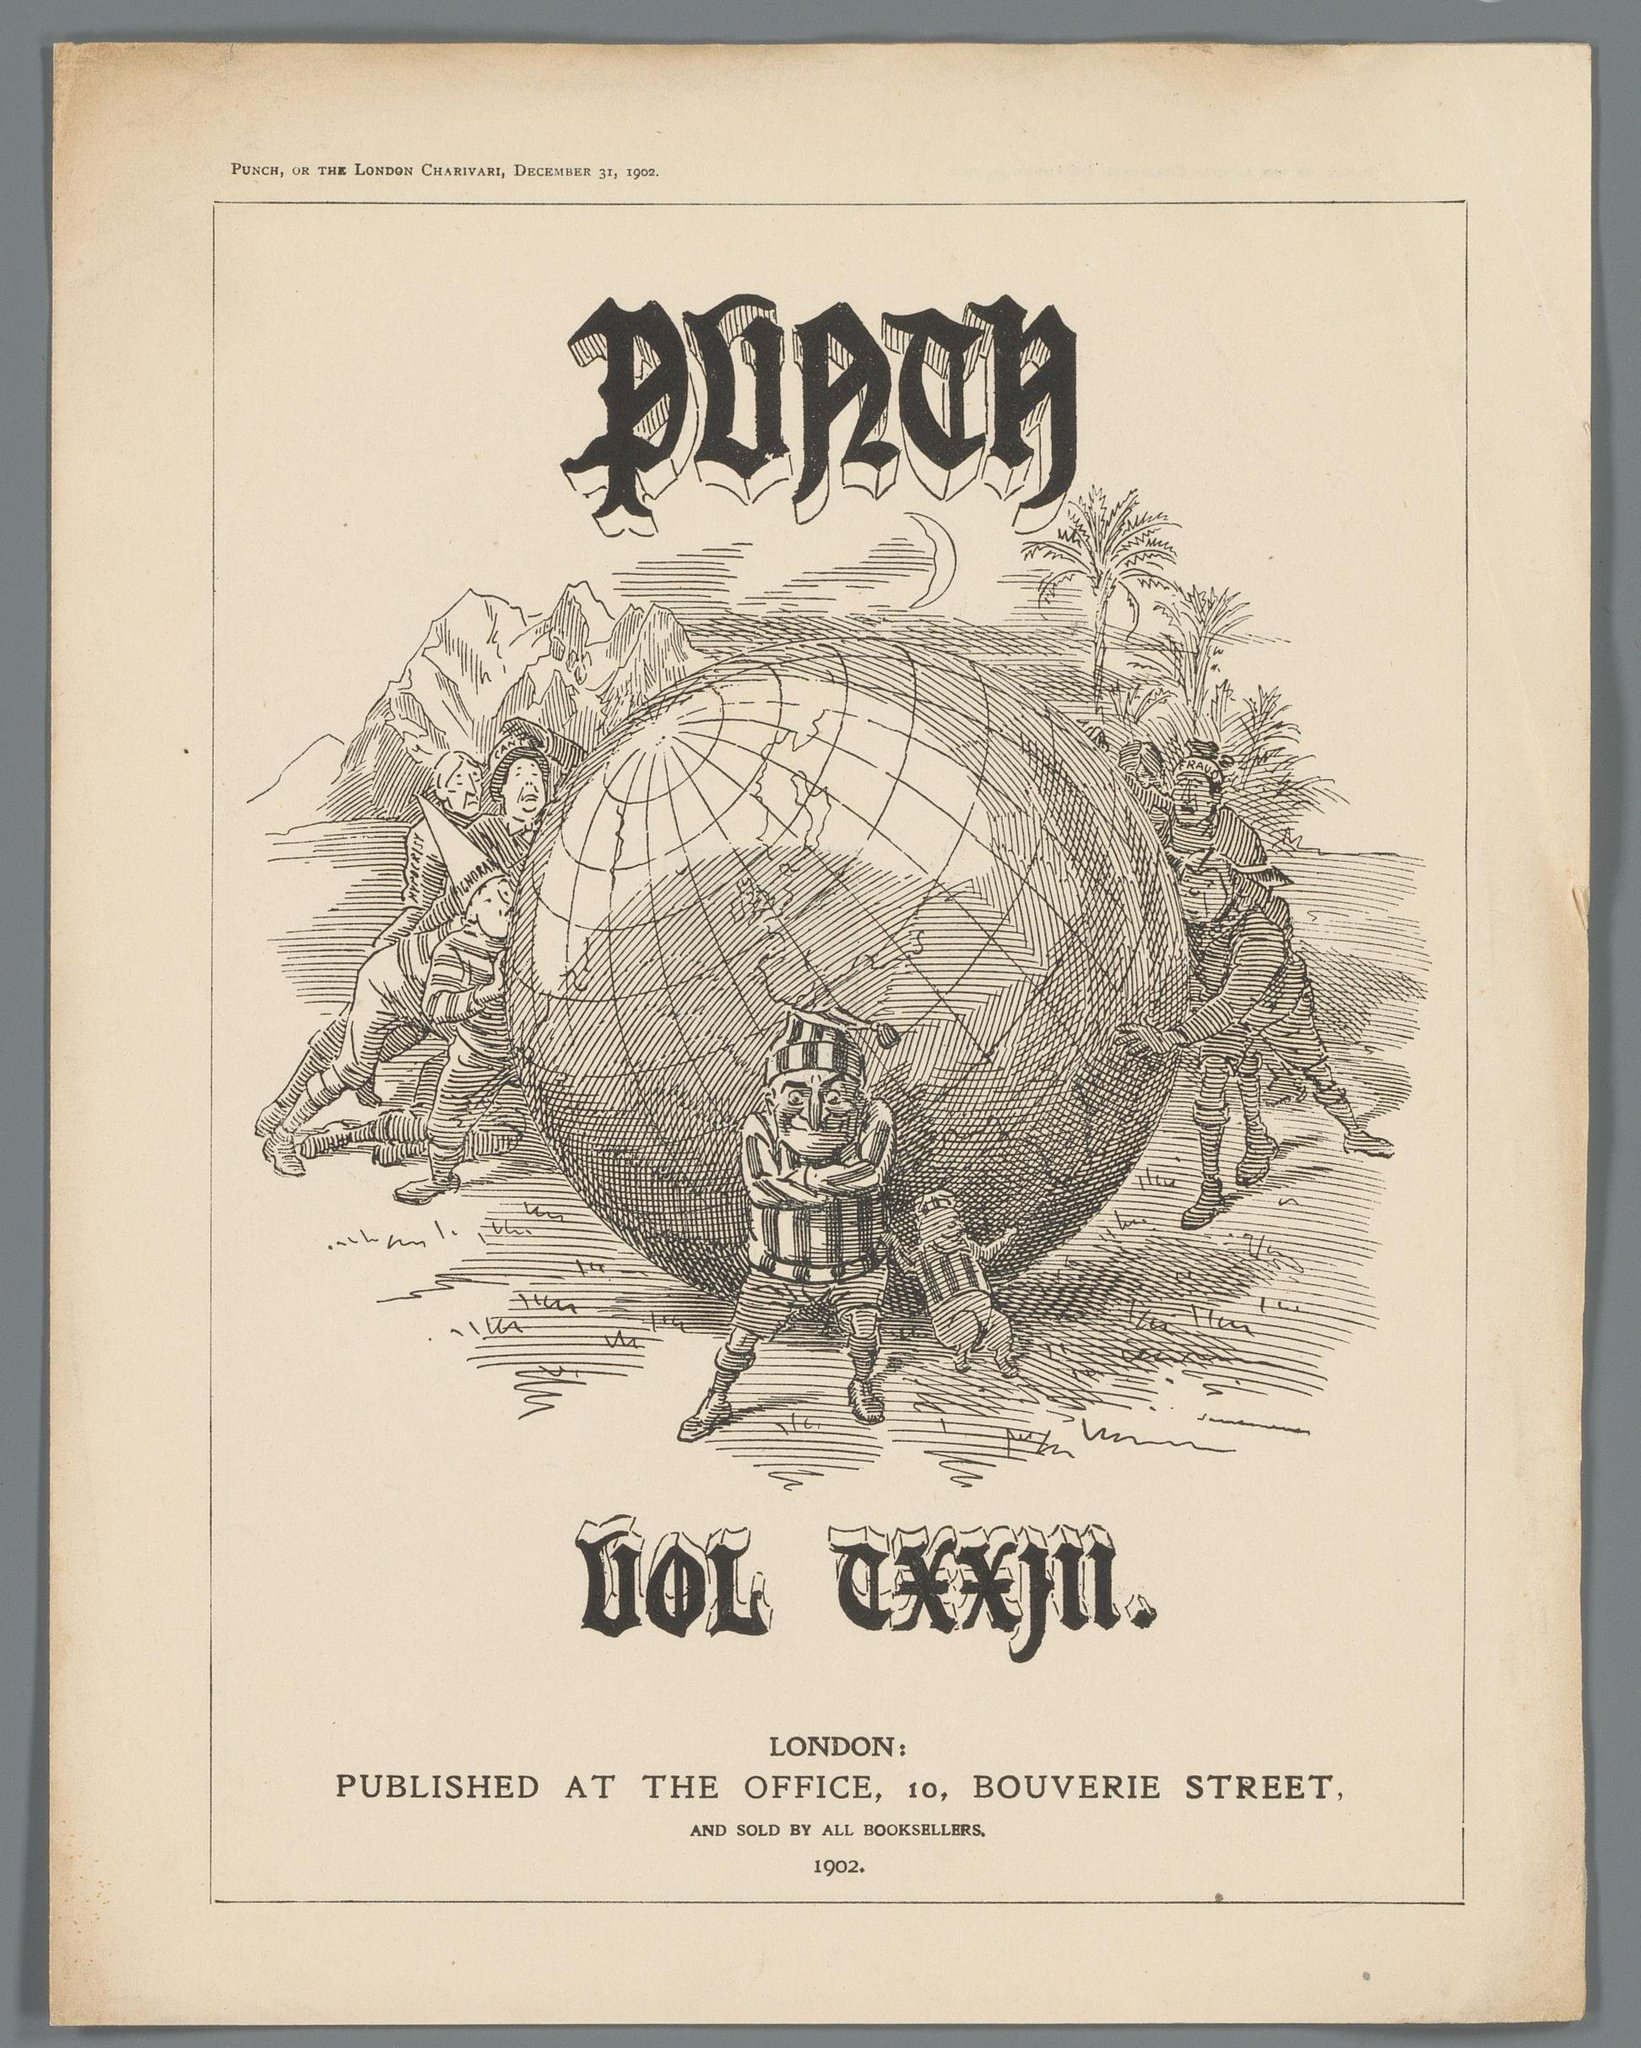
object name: print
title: Spotprent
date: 1902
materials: paper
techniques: line block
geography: england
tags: globe, political caricatures and satires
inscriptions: date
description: Spotprent met Mr. Punch die voorkomt dat andere buitenlandse volken de wereldbol omduwen. Spotprent uit het Engelse satirische tijdschrift Punch, 1898.